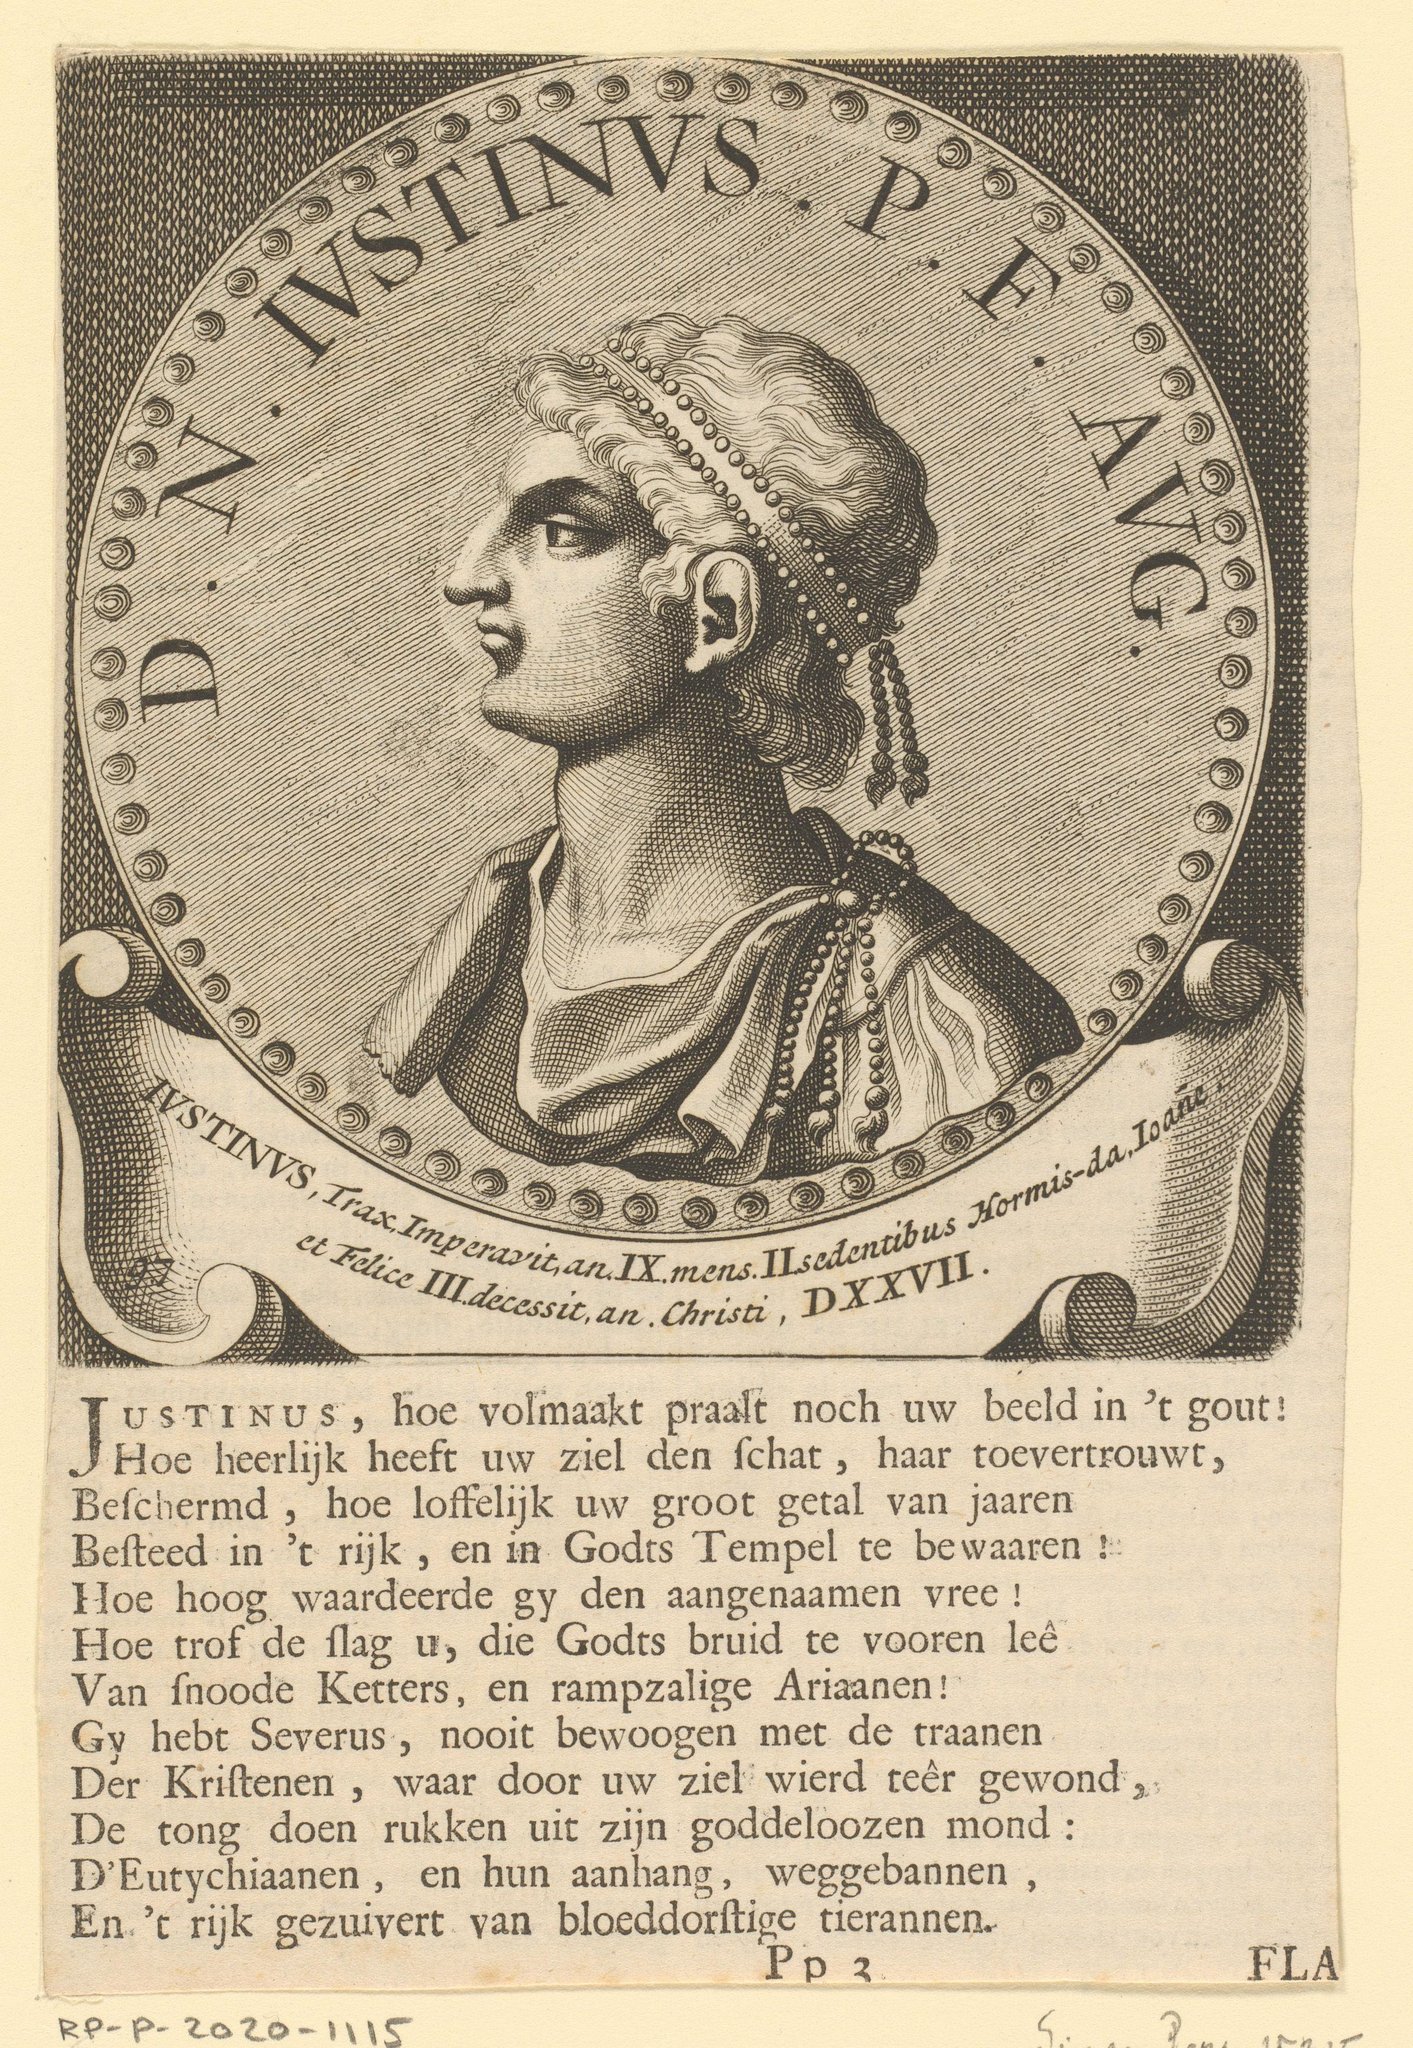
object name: print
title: Justinus, Trax (...)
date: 1697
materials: paper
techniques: engraving, etching, letterpress printing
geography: utrecht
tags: historical persons, emperor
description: Prent uit: Bogaert, Abraham. De Roomsche monarchy, vertoont in de muntbeelden der westersche en oostersche keizeren (...). Utrecht: François Halma en Willem van de Water, 1697, p. 301. Eerste staat verschenen in een grotere prent met twaalf portretten, gedateerd 1695.